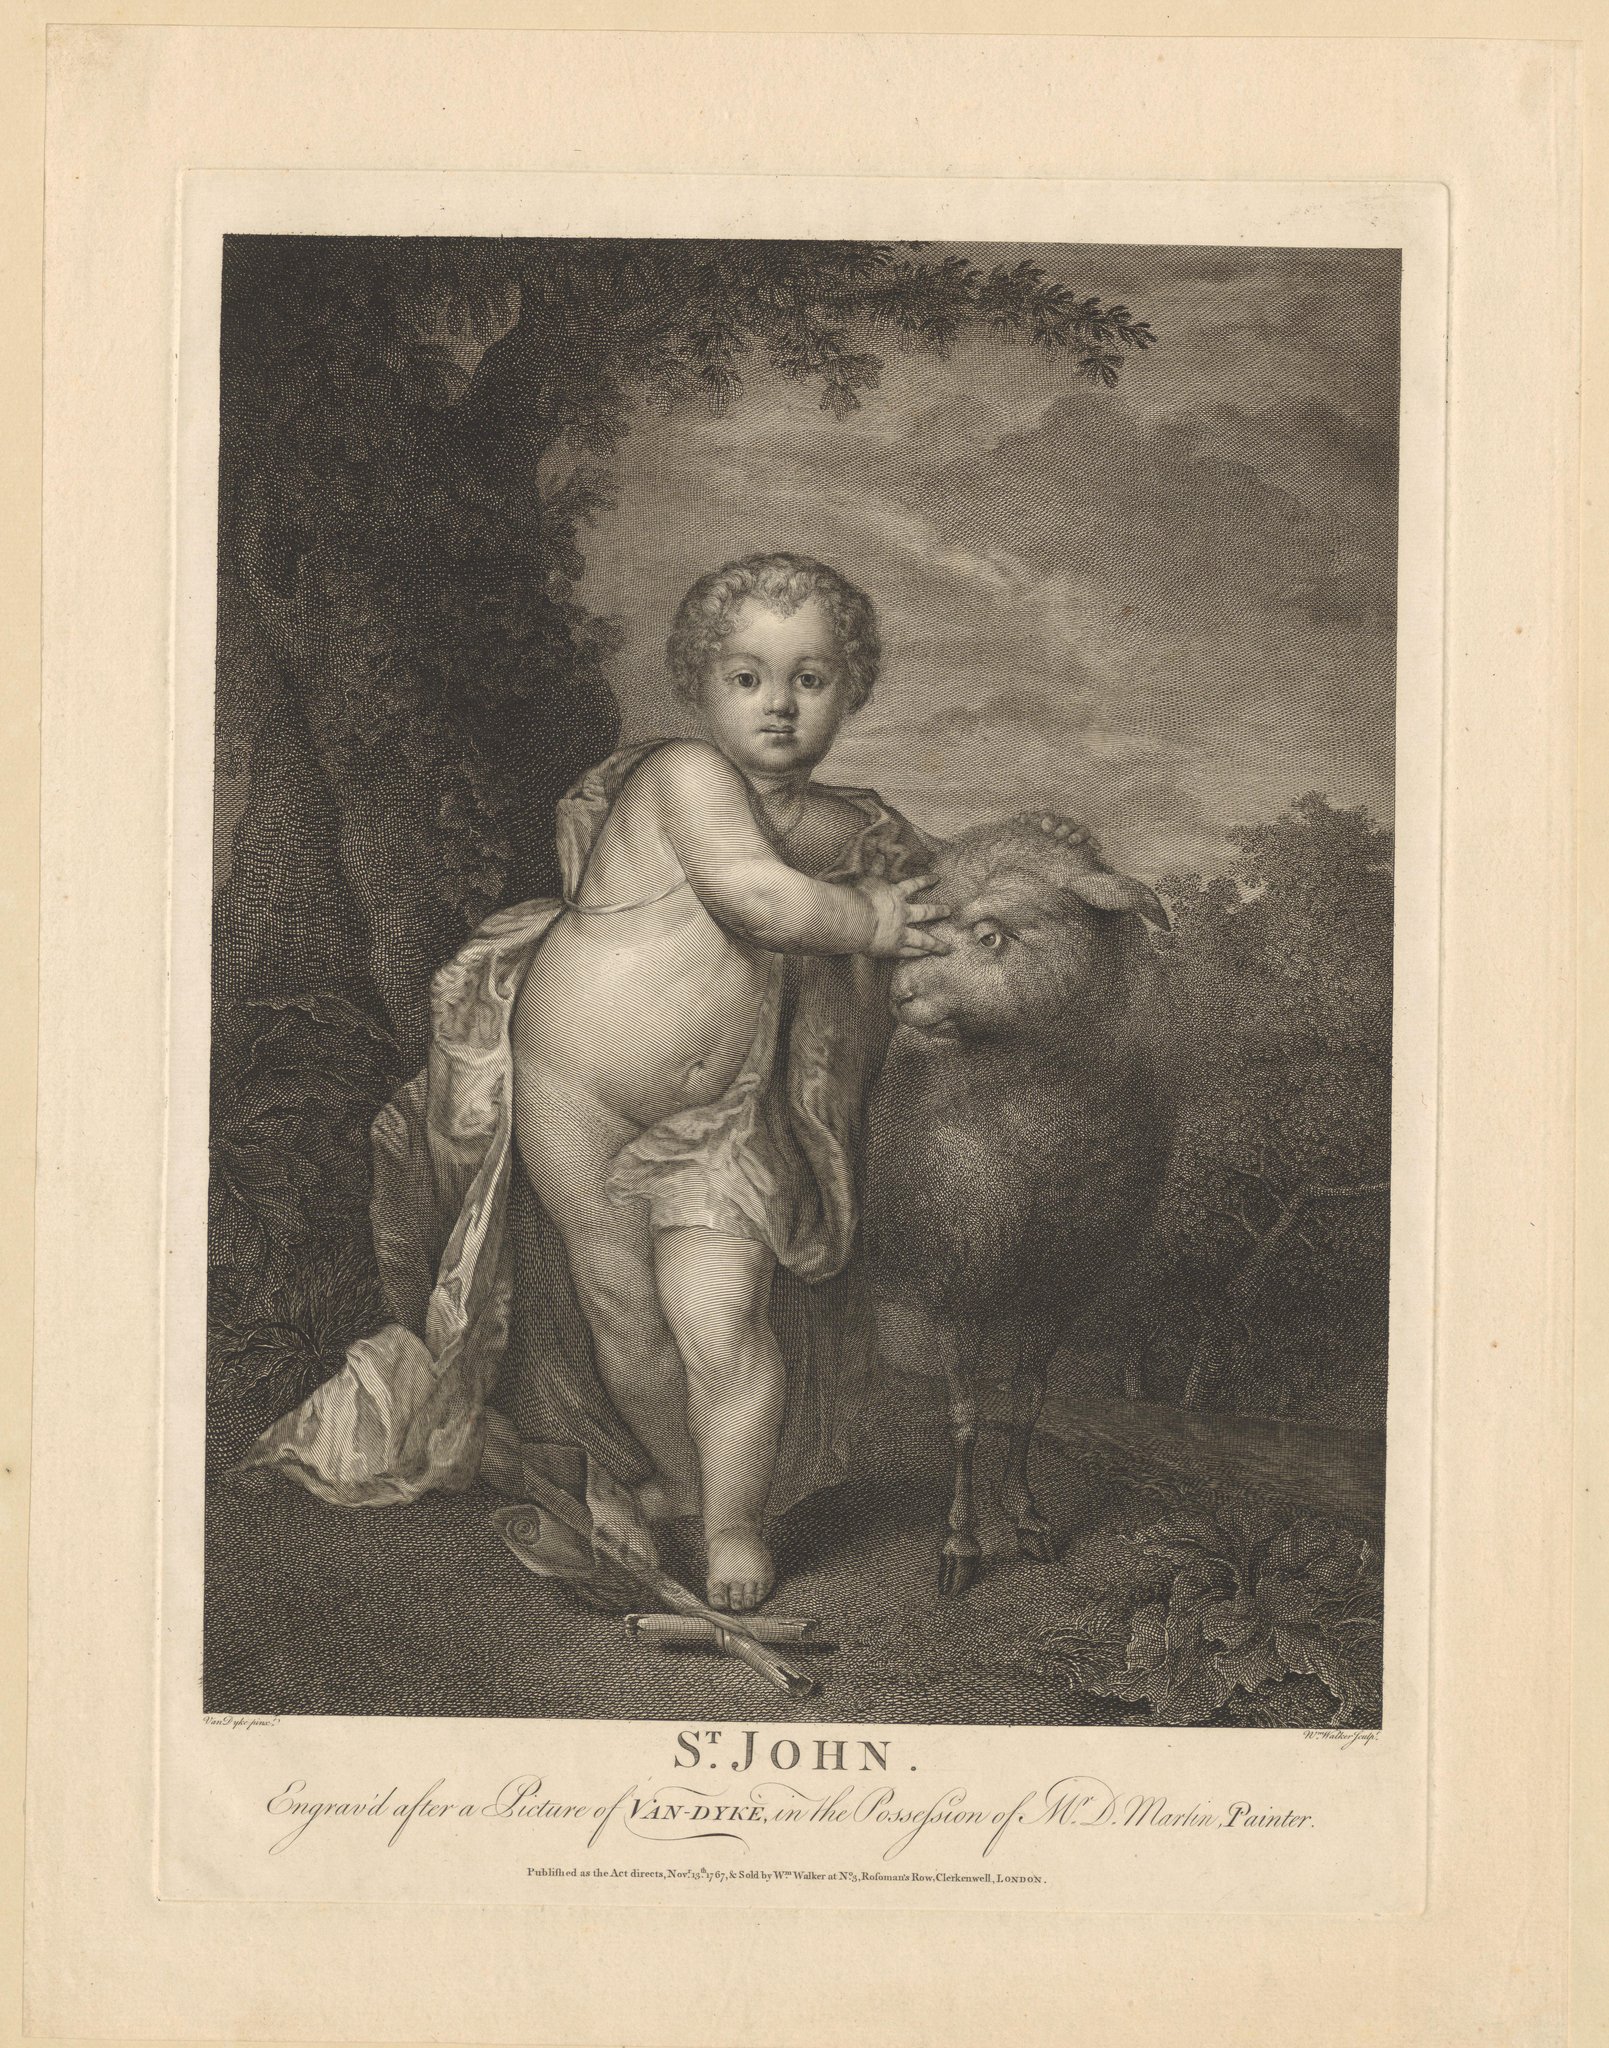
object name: print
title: Johannes de Doper in de wildernis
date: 1767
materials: paper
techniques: engraving, etching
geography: london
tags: john the baptist in the wilderness, usually accompanied by a lamb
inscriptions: collector's mark: Lugt 240